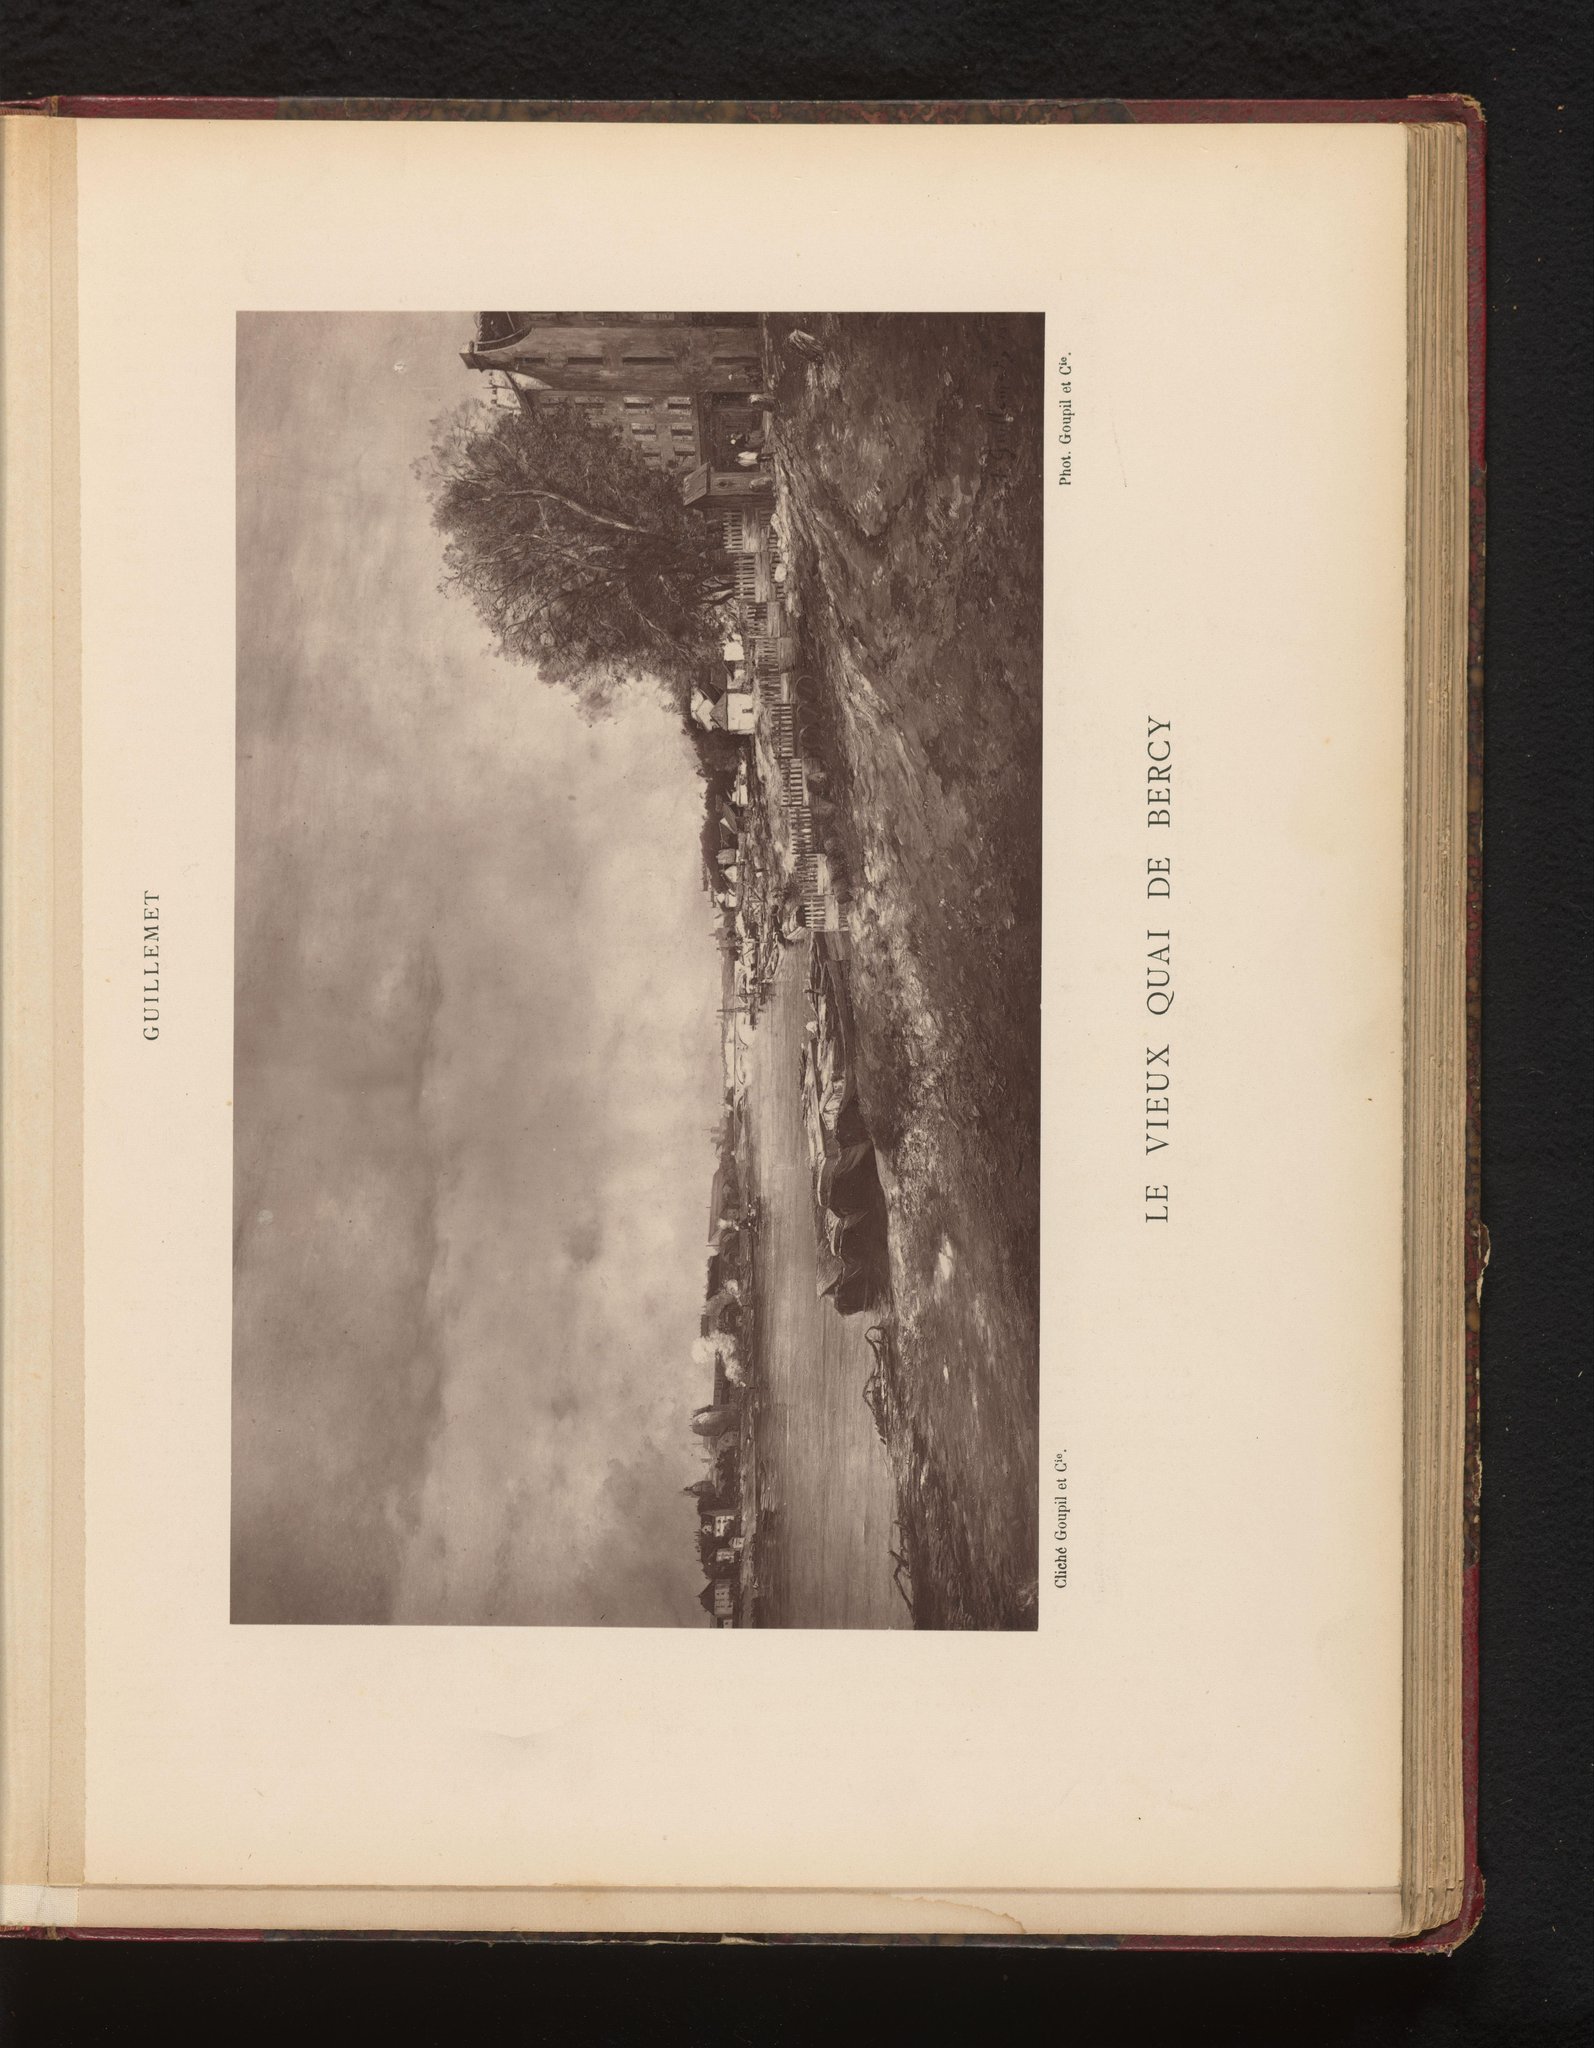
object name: photomechanical print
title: Fotoreproductie van het schilderij 'Le vieux quai de Bercy' door Antoine Guillemet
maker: jean-baptiste-antoine guillemet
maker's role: painter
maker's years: 1843-1918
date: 1880-1881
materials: paper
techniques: woodburytype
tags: city-view in general; 'veduta', paris